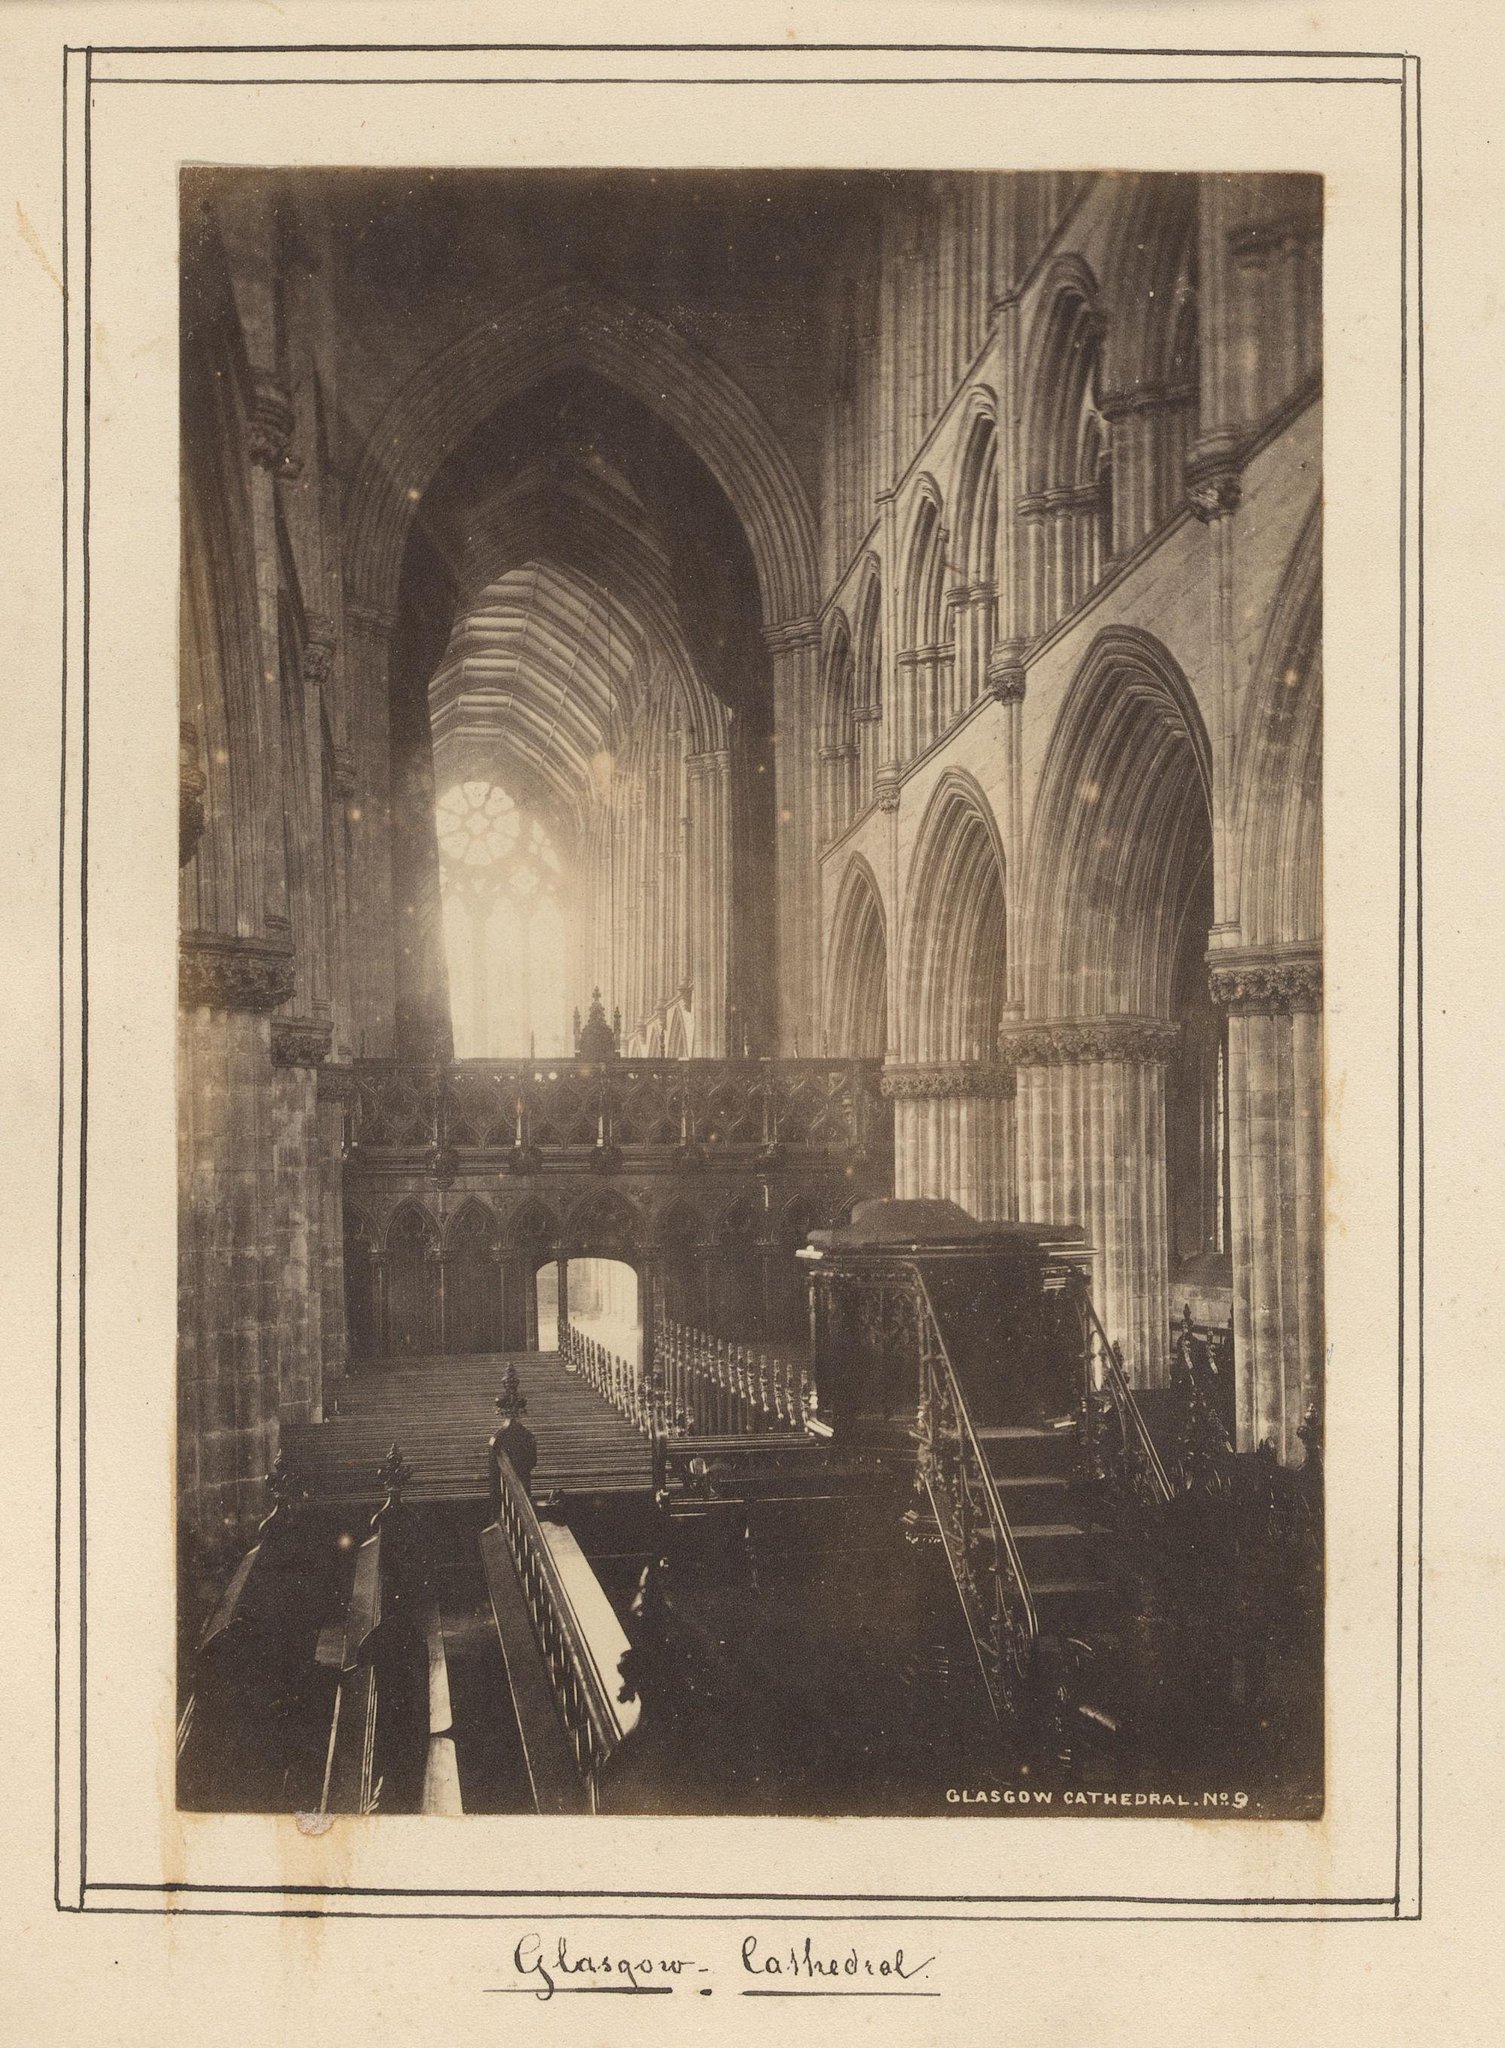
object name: album leaf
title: Crypte van de kathedraal van Glasgow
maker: Anonymous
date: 1870-1890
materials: paper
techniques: albumen print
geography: glasgow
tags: parts of church interior (crypt)